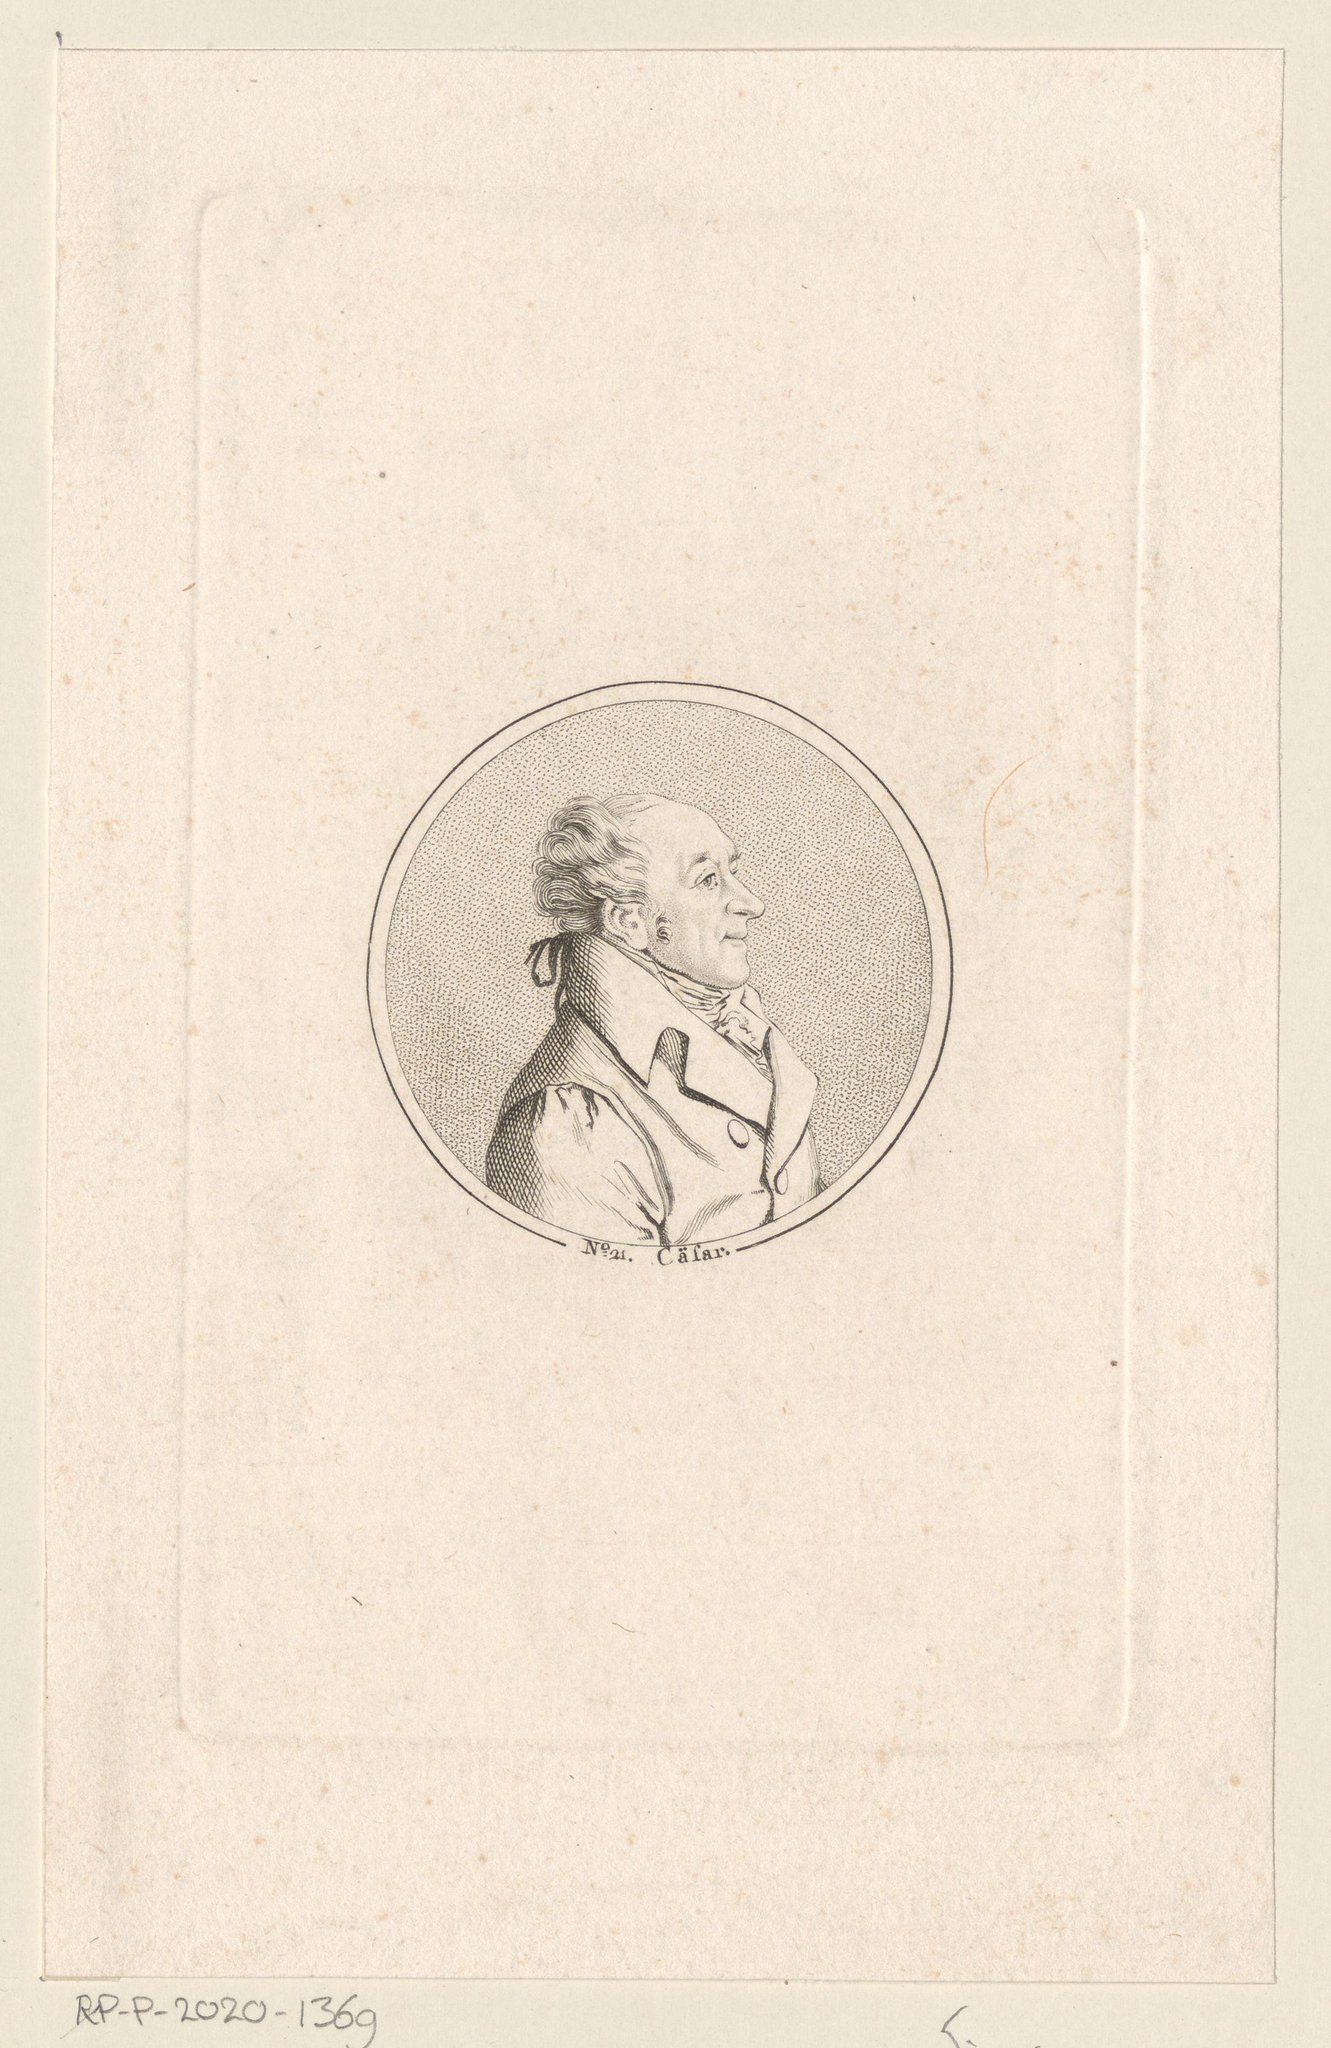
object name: print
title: Portret van Karl Adolph Caesar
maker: w. urndt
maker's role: print maker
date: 1810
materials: paper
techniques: engraving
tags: historical persons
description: Prent ook gebruikt in: Kreussler, Heinrich Gottlieb. Autobiographieen Leipziger gelehrten. Leipzig: J. B. Fleischers, 1810, tussen pagina 60 en 61.